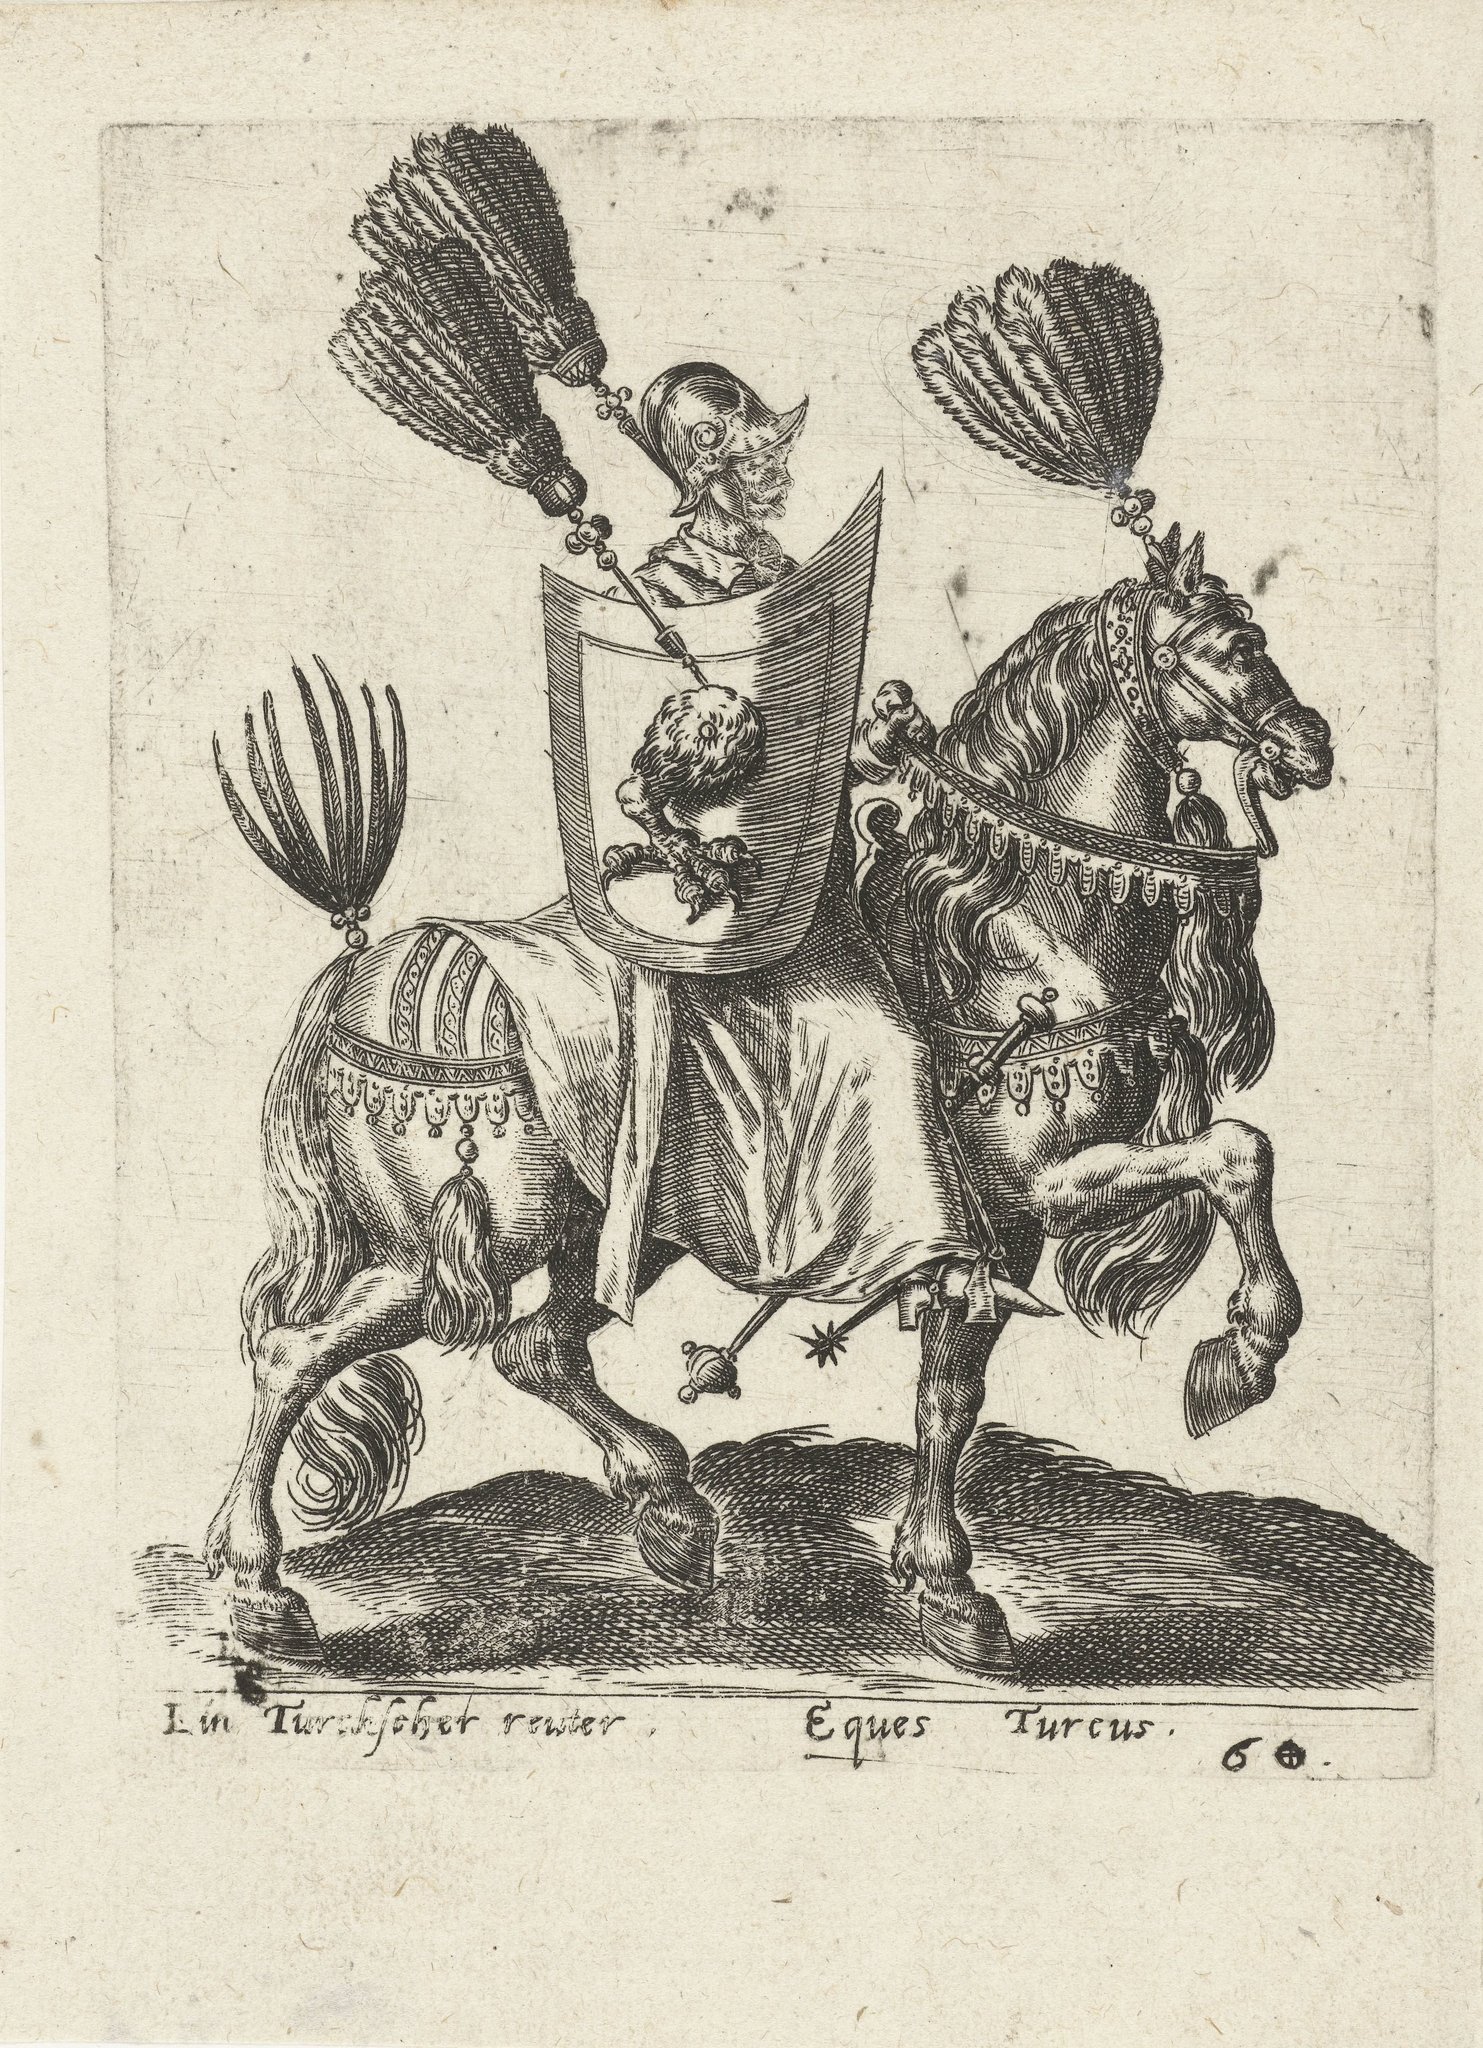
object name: costume print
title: Een Ottomaanse ruiter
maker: abraham de bruyn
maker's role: print maker, publisher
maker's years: 1540-1587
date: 1577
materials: paper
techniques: engraving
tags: asiatic races and peoples: turks, warfare; military affairs (+ cavalry, horsemen), folk costume, regional costume, (military) uniforms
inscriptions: collector's mark: Lugt 2228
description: Paard en ruiter naar rechts. Het paard is in stap. De ruiter is in Ottomaanse stijl gekleed. Hij heeft een schild in zijn hand. De prent heeft een Duits en Latijns onderschrift. Prent oorspronkelijk uit 'Equitum descripcio...', 1577.